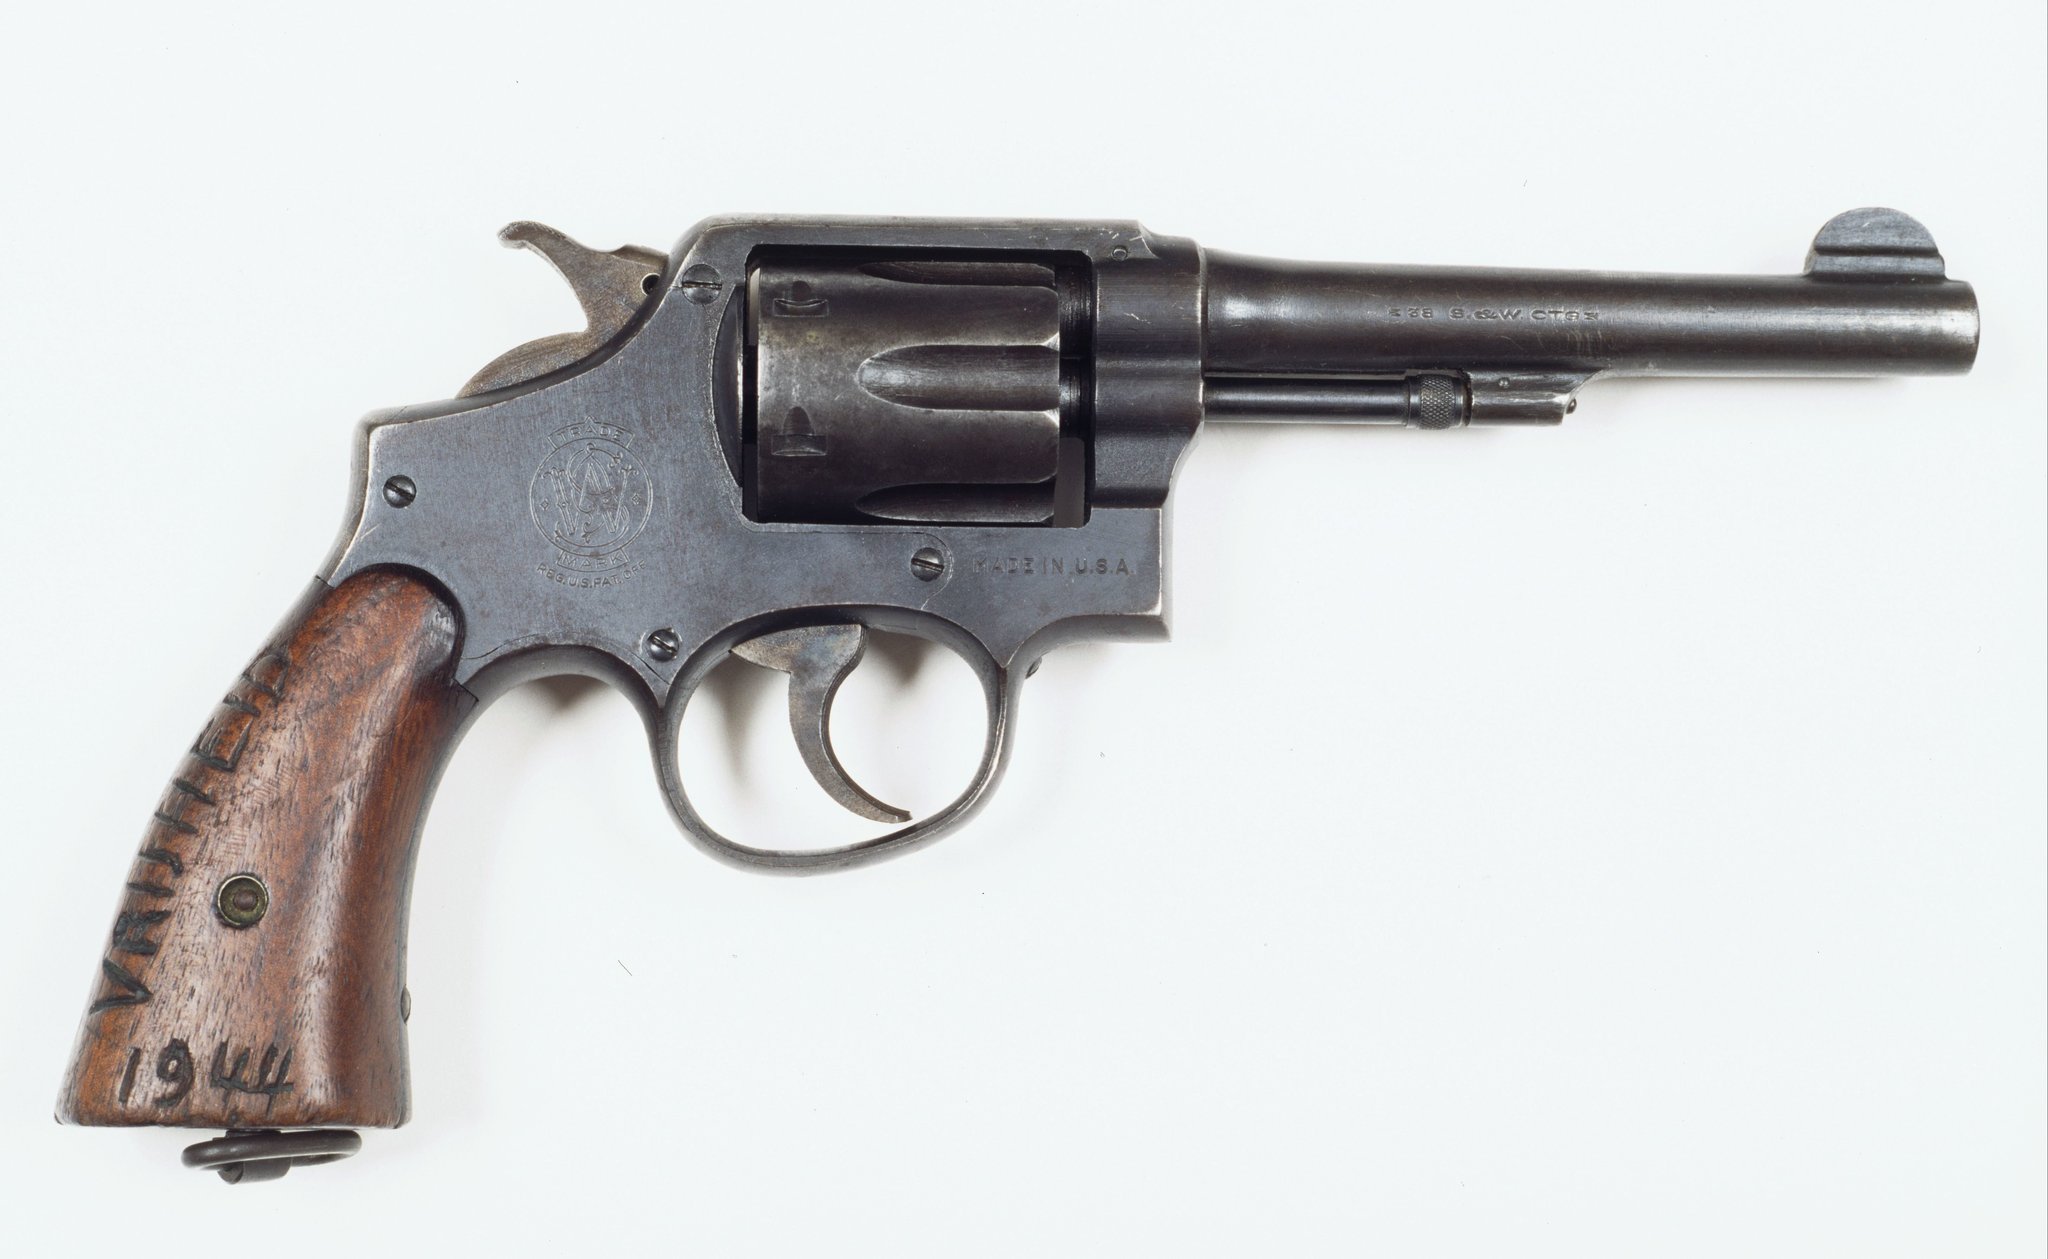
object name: revolver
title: Revolver met holster van Tonny van Renterghem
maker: hunter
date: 1920-1944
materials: copper, leather, steel, wood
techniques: casting, sewing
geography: springfield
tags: amsterdam, tonny van renterghem, netherlands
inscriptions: inscription: ‘Hunter’, mark: ‘17640’, mark: ‘V566938’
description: Revolver, Smith & Wesson 38, van Tonny van Renterghem, afkomstig van een wapendropping voor het verzet in de Tweede Wereldoorlog in Nederland. Op de houten kolf een inscriptie 'Vrijheid 1944'. Registratienummer: V 566938. Aan de kolf een ijzeren ring. In bijbehorend holster van leer met brede lus ter bevestiging aan de broekriem.